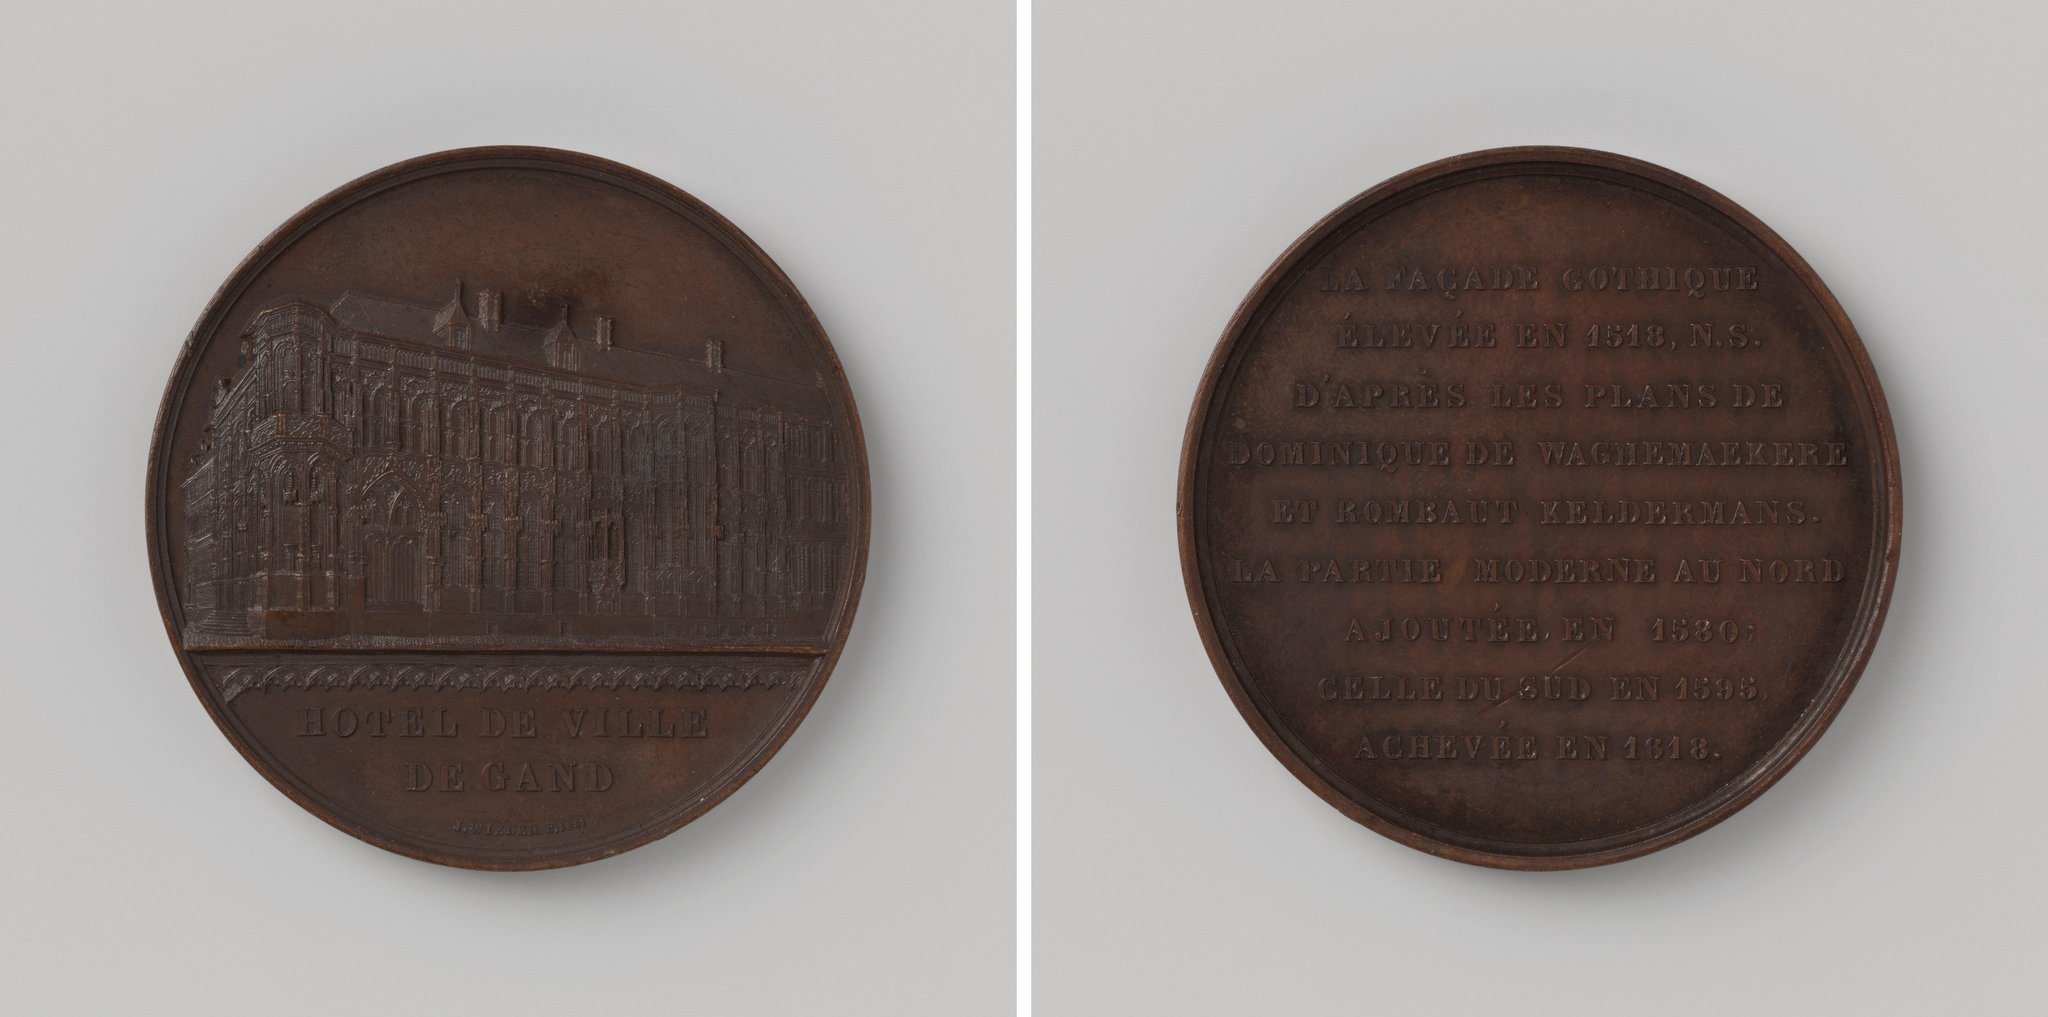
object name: history medal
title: Stadhuis te Gent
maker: jacob wiener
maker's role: medailleur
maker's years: 1815-1899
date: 1851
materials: bronze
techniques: striking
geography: brussels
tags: stadhuis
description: Bronzen penning. Voorzijde: stadhuis; afsnede: opschrift en signatuur onder sierrand. Keerzijde: opschrift